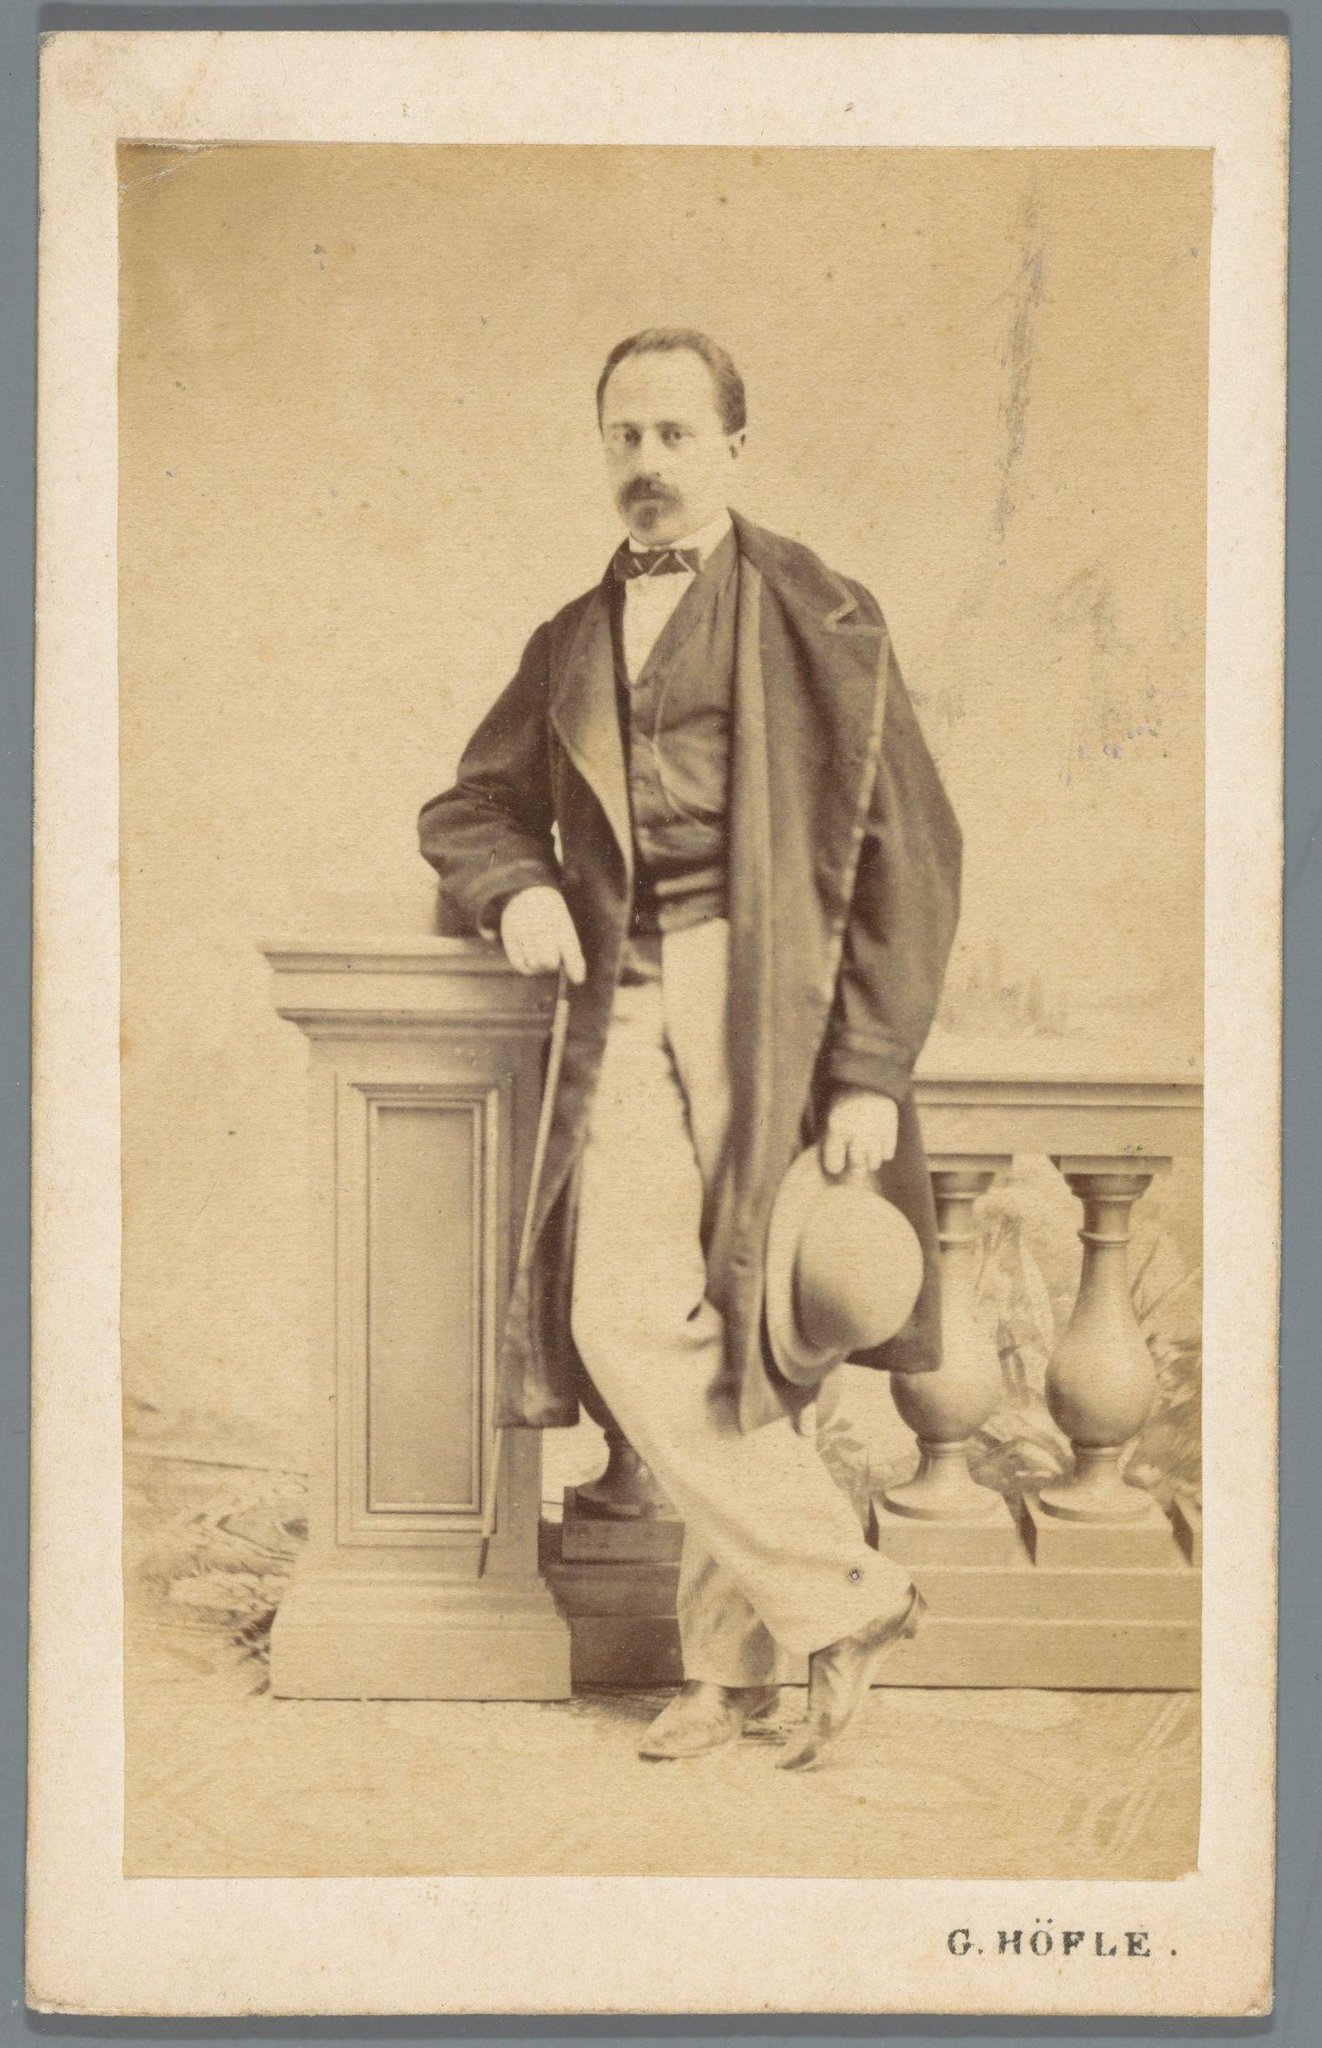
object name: carte de visite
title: Portret van een onbekende man met hoed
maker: g. höfle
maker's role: painter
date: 1855-1885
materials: cardboard, paper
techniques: albumen print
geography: innsbruck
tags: adult man, anonymous historical person portrayed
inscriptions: inscription: ‘Photographie/ von/ G. Höfle, Maler./ Atelier,/ Museumstrasse No 623./ Insbruck’, inscription: ‘G. Höfle.’